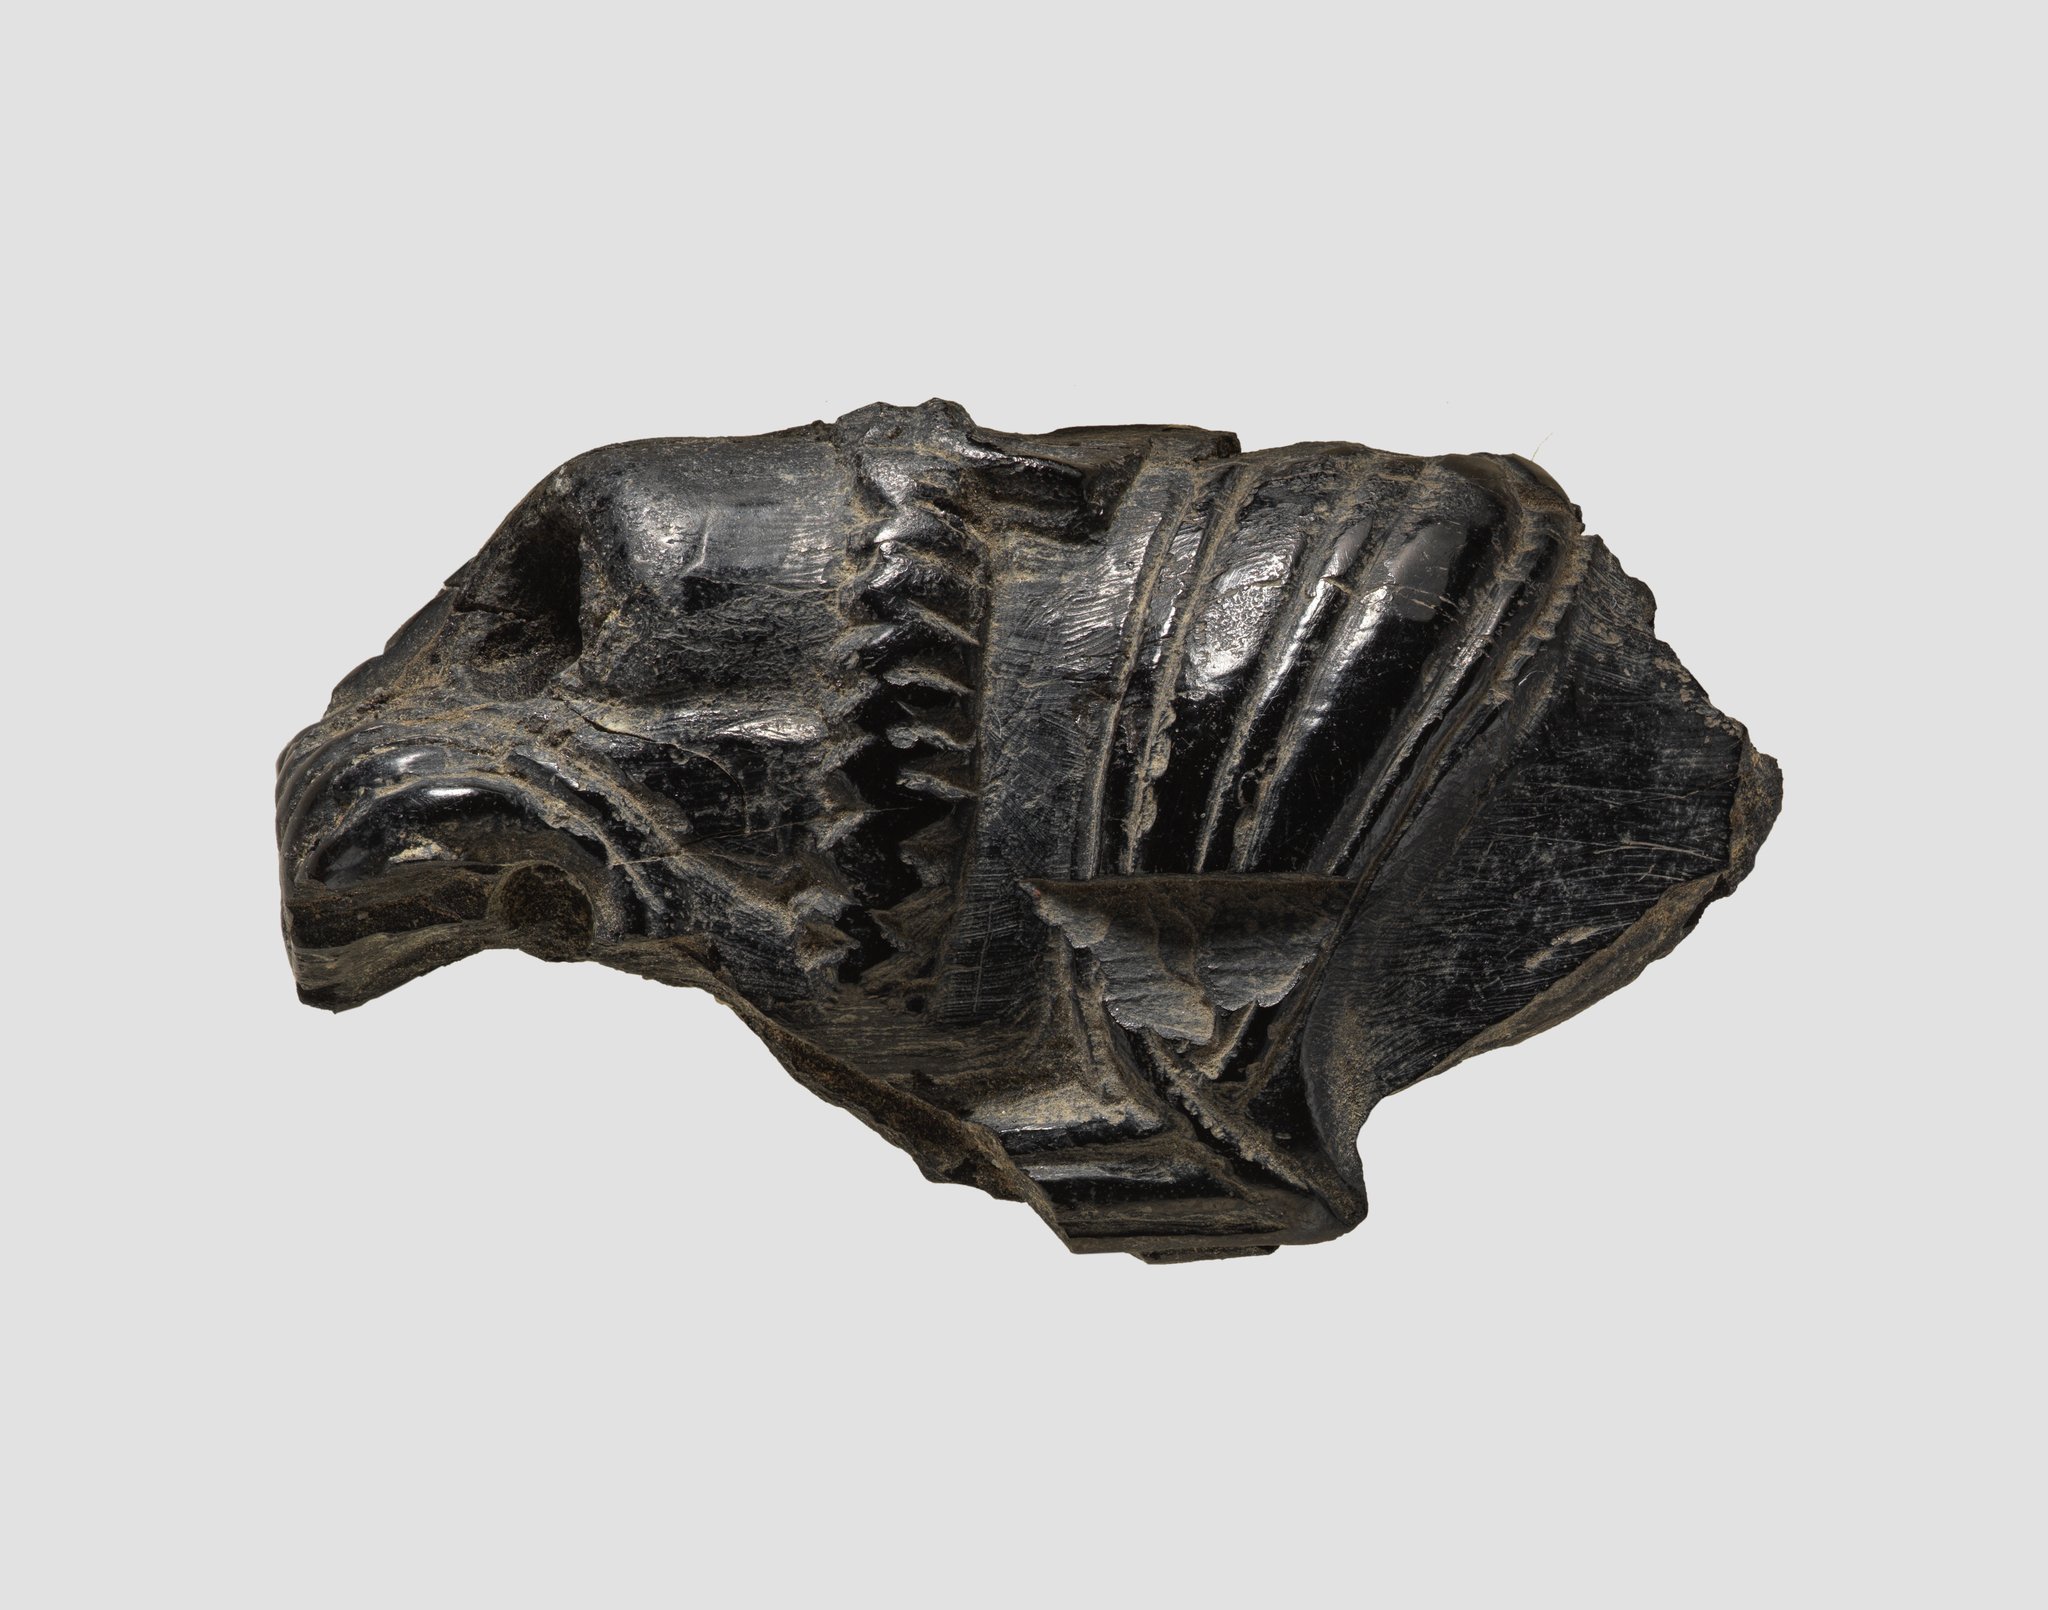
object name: relief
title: Ivory fragment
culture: iranian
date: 900-801 BCE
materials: ivory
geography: iran